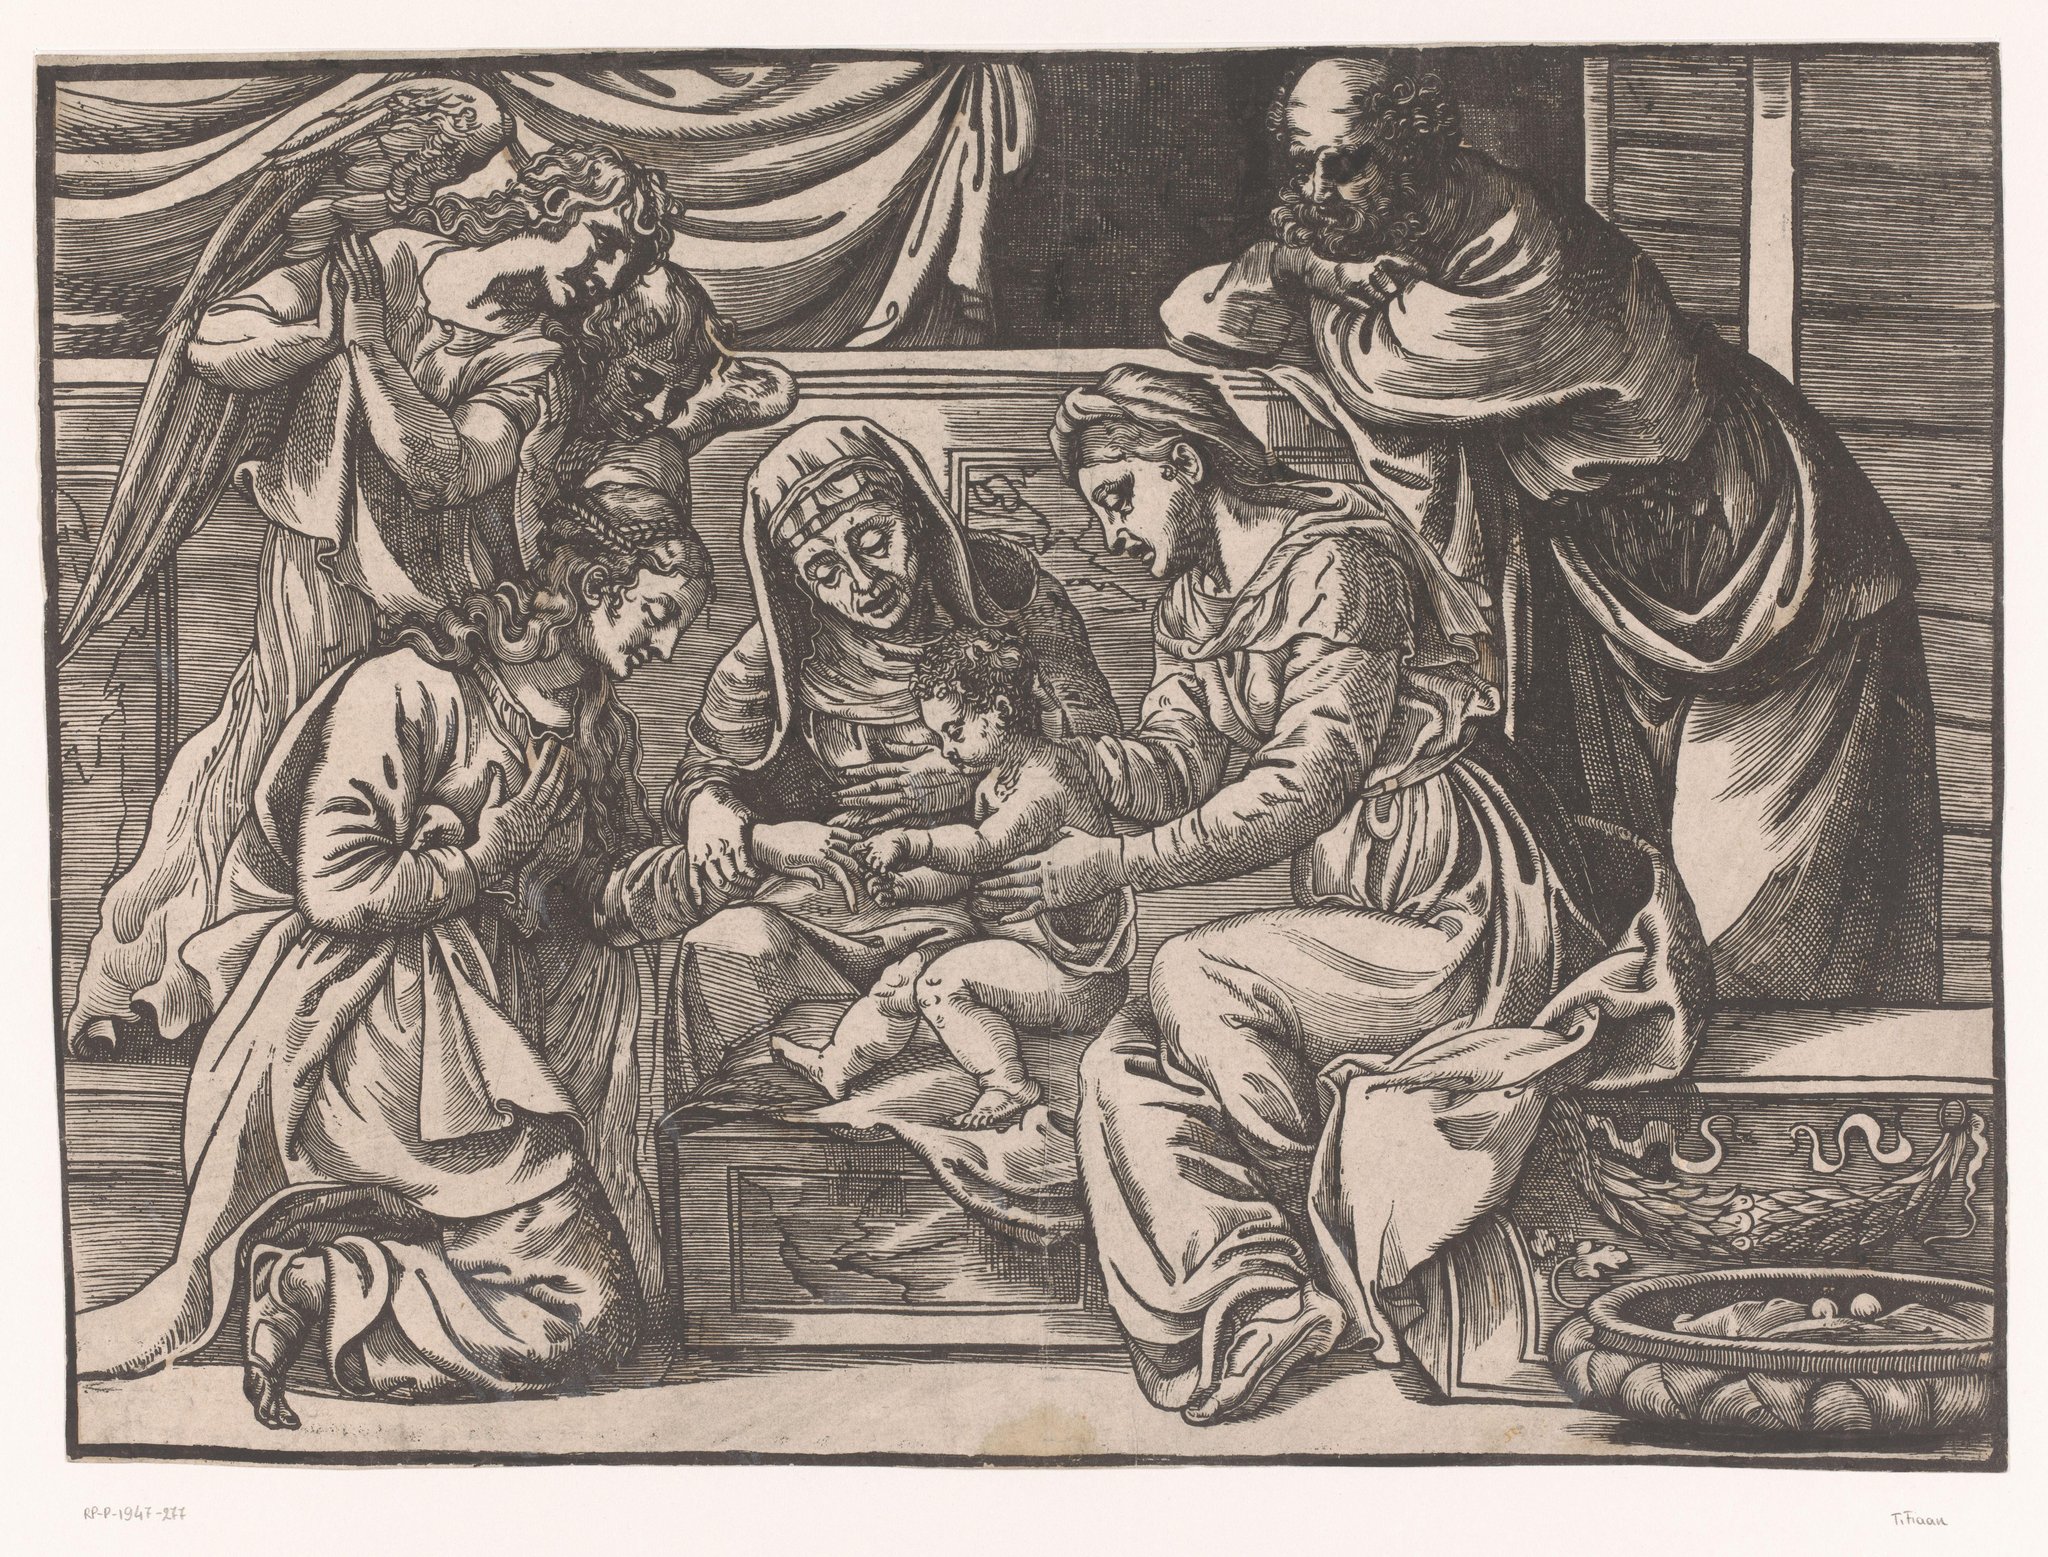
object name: print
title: Mystieke huwelijk van de heilige Catharina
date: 1540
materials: paper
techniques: woodcut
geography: venice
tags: the foster-father of christ, joseph of nazareth, husband of mary; possible attributes: flowering rod or wand, lily, carpenter's tools, the mystic marriage of st. catherine of alexandria with the infant christ: the christ-child puts a ring on her finger, angels in adoration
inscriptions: collector's mark: Lugt 2228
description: Maria houdt het Christuskind vast terwijl deze een ring om de vinger schuift van de heilige Catharina die voor hem knielt. Links twee aanbiddende engelen en rechts Jozef. In het midden een oudere vrouw, mogelijk de heilige Anna.